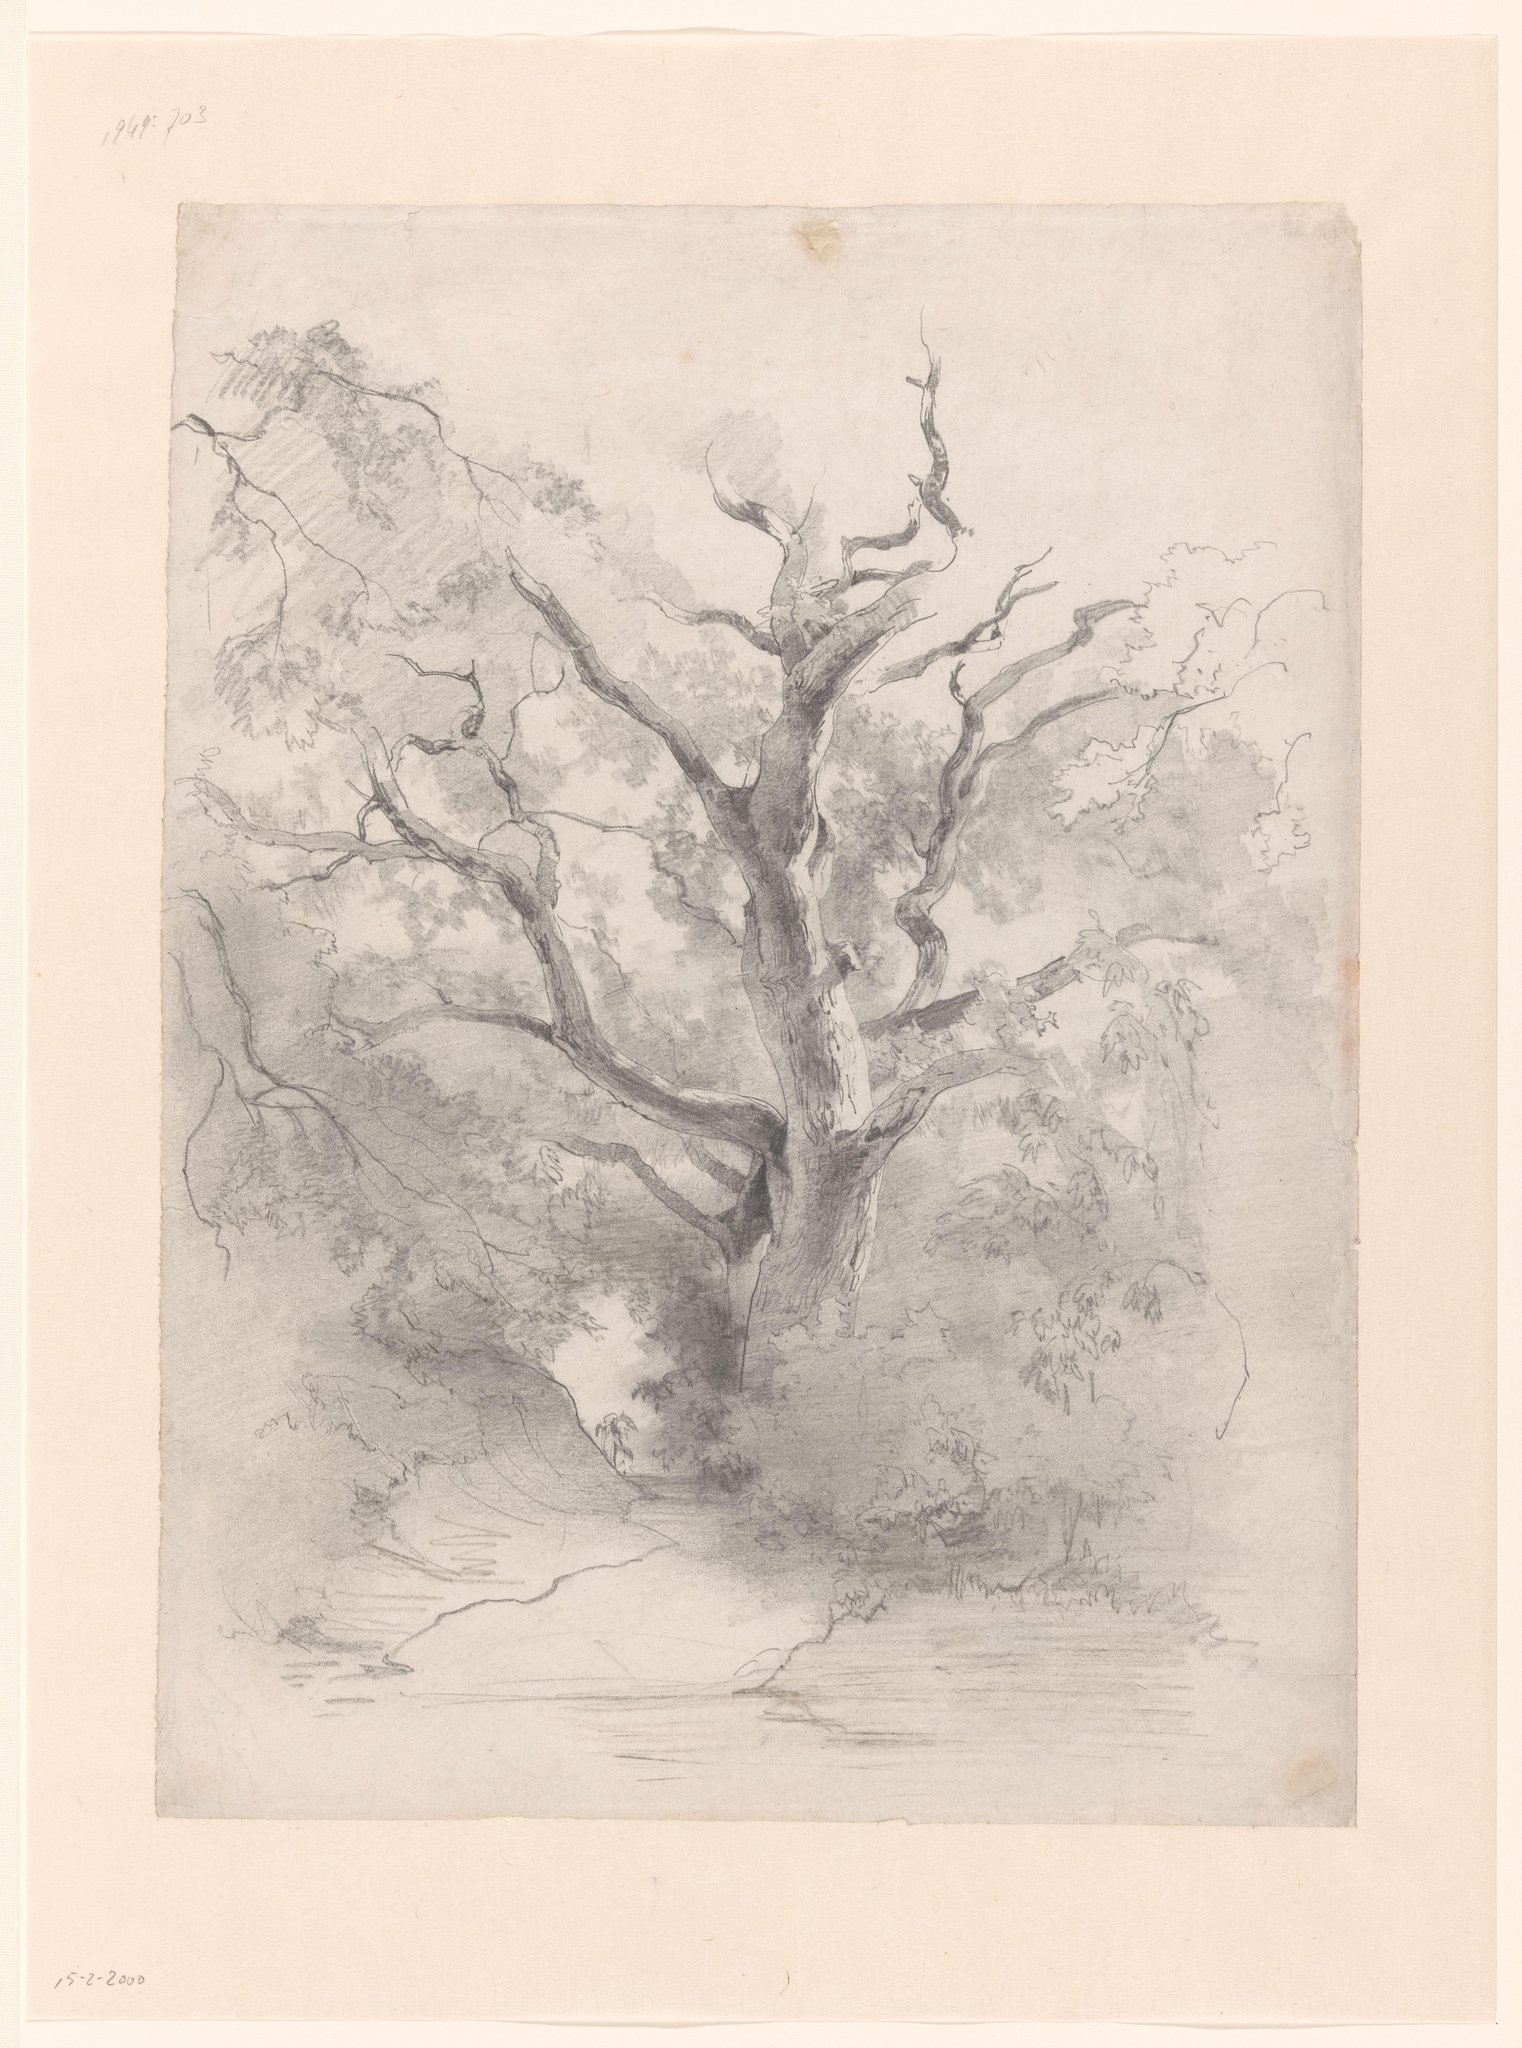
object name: drawing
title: Boomstudie, van een oude eik in een bos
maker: karel elias van toulon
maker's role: draughtsman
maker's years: 1816-1852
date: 1826-1852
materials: paper, pencil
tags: trees